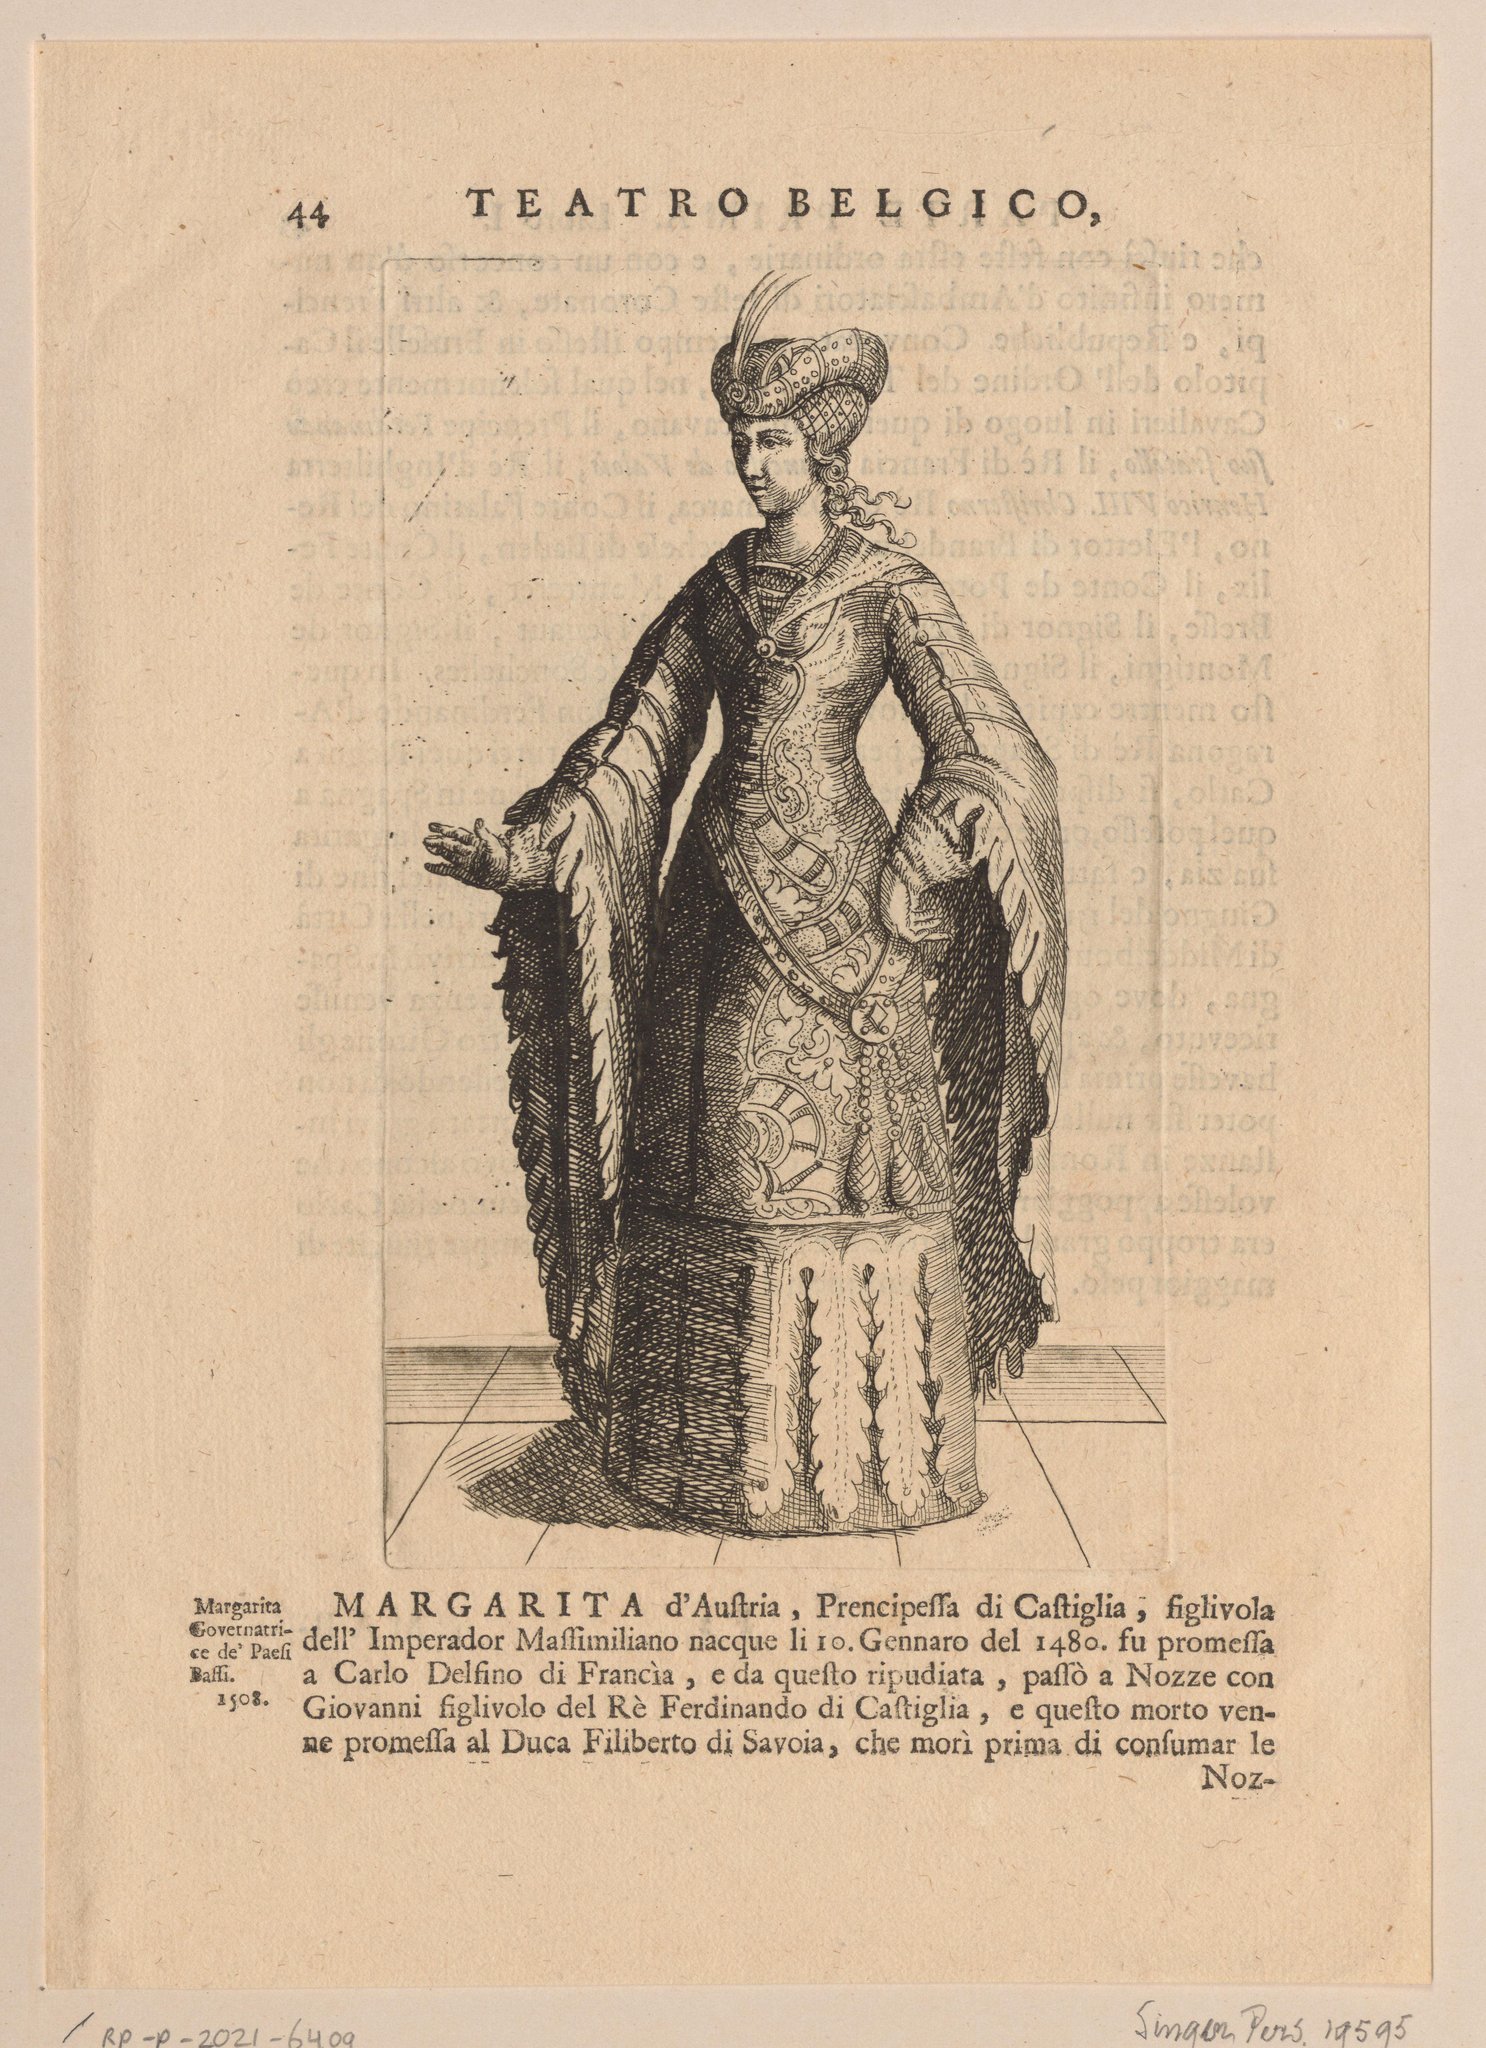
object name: print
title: Portret van Margaretha van Oostenrijk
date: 1690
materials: paper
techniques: etching, letterpress printing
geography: northern netherlands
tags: brussels, mechelen, historical persons - bb - woman, regent, substitute ruler; viceroy - bb - female ruler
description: Prent uit: Leti, Gregorio. Teatro Belgico, o verso ritratti historici, chronoligici, politici, e geografici (...). Amsterdam: Willem de Jonge, 1690, dl. 1, p. 44.